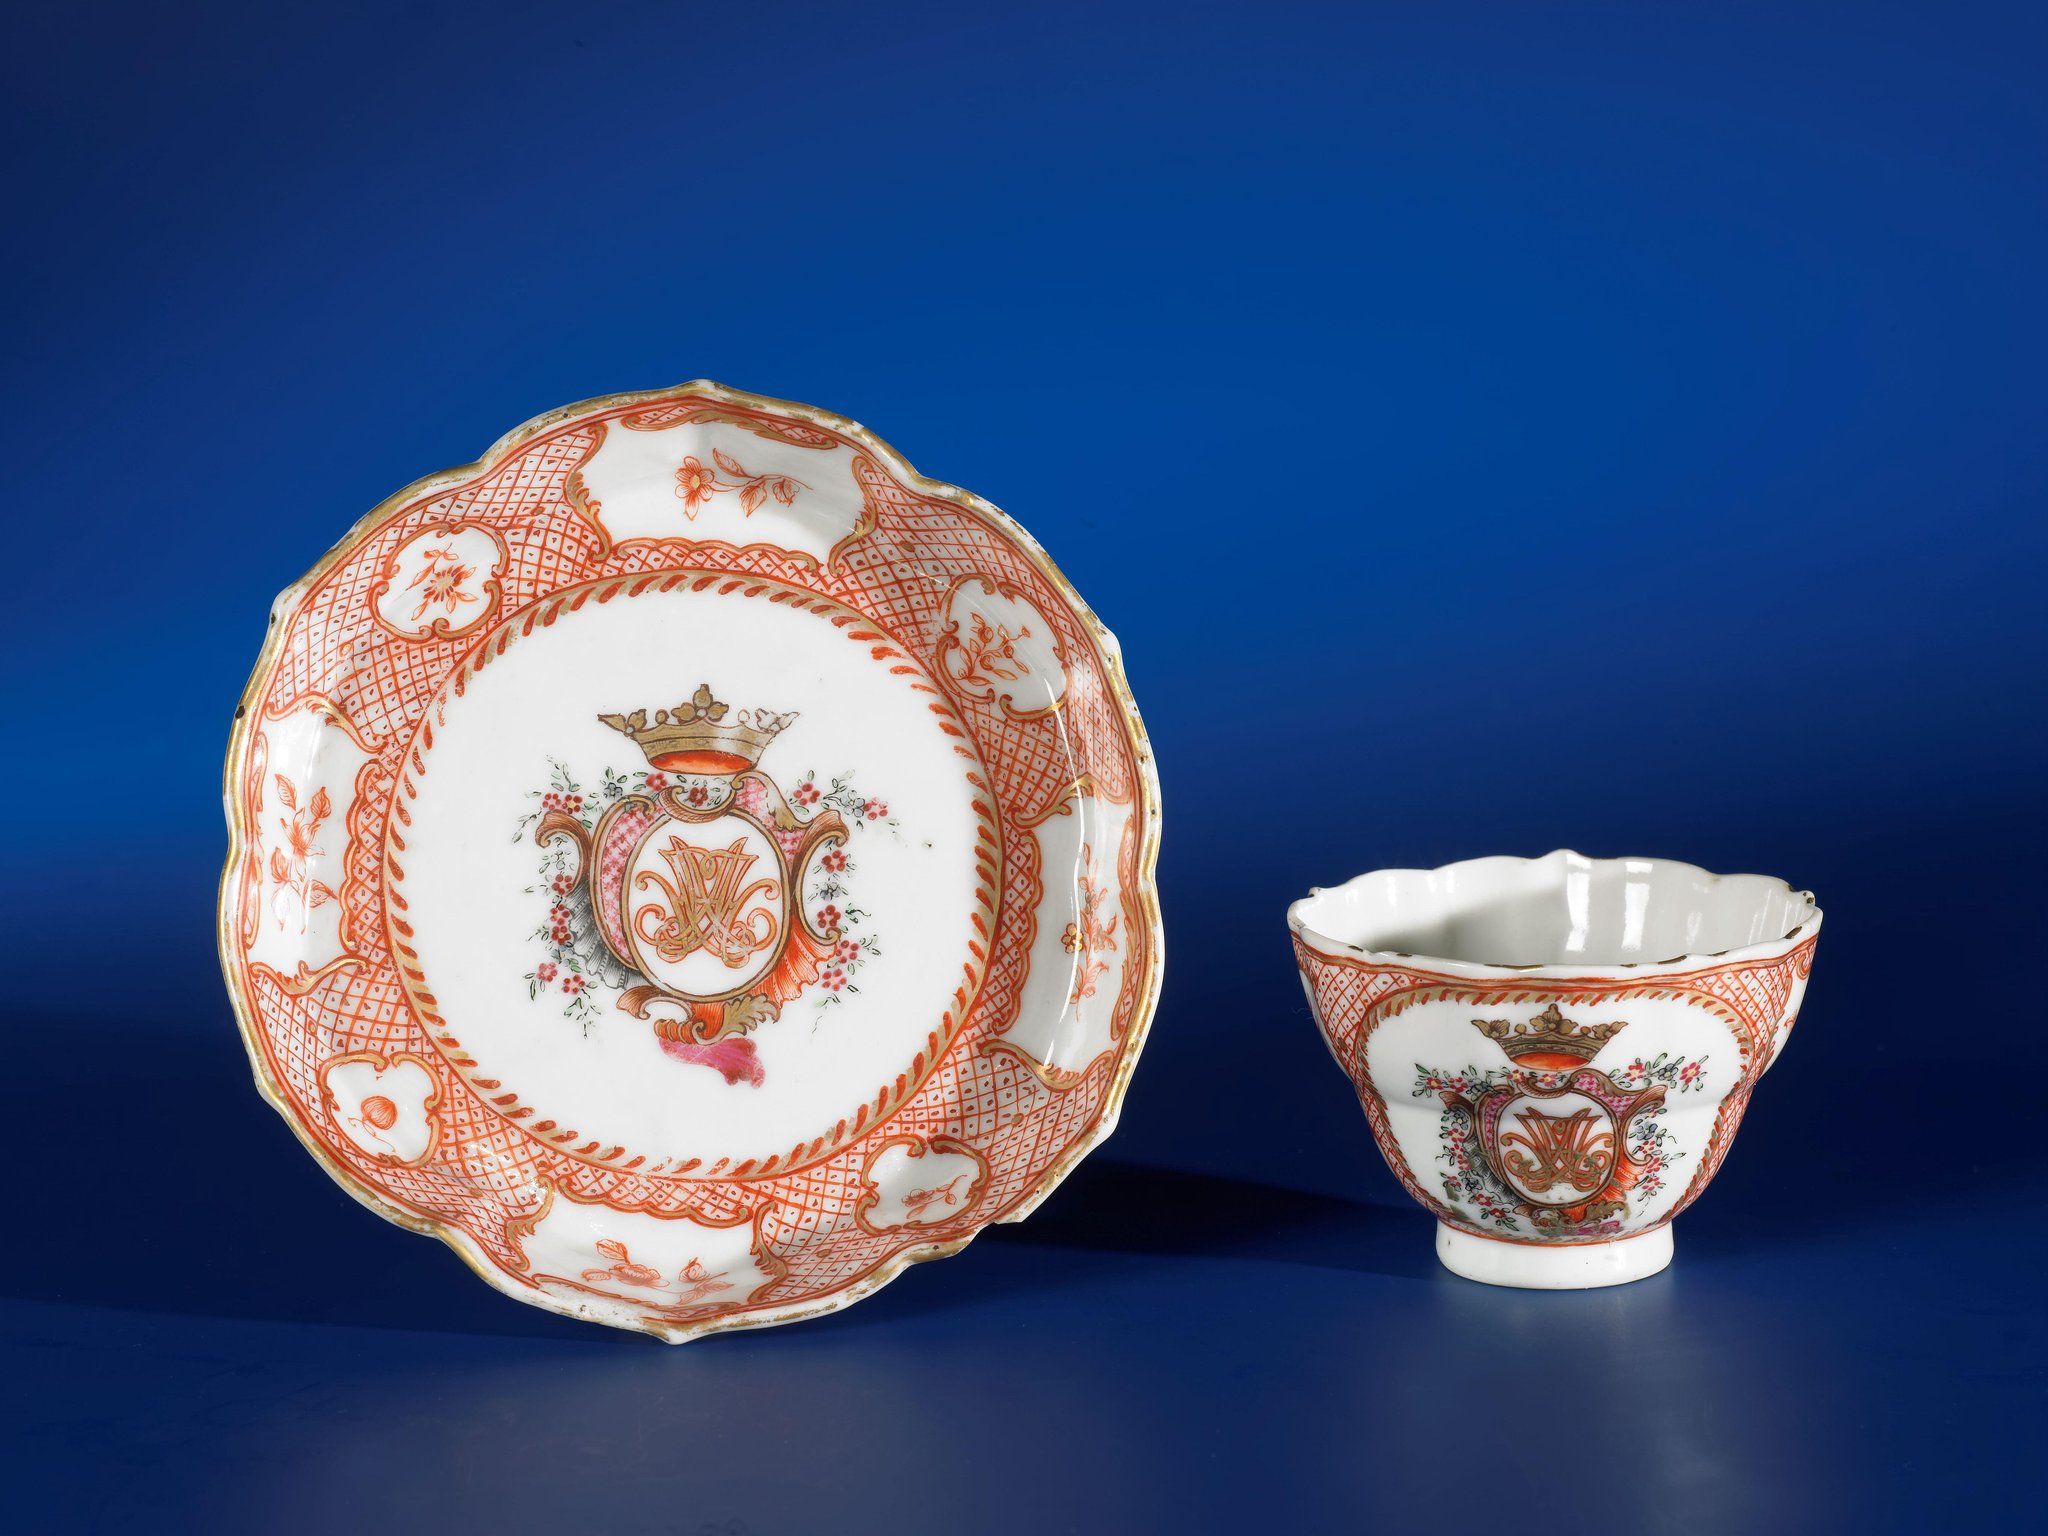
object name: platter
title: Saucer with a monogram in a crest in a medallion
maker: Anonymous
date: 1725-1749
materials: glaze, gold, paint, porcelain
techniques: firing, gilding, turning, vitrification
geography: china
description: Schotel chotel met een korte, rechte, geribde wand en accoladevormige rand van porselein, beschilderd op het glazuur in blauw, rood, roze, groen, geel, zwart en goud. Op het plat van de schotel het monogram 'JM' in een gekroond medaillon met schelpmotief, servetwerk en bloemtakken; om het medaillon en op de wand servetwerk met hierin uitgespaard vier kleine en vier grote cartouches met bloemtak. Onderzijde van de schotel ongeglazuurd. Een barst en twee chips in de wand van de schotel. Europese voorstelling in emailkleuren.